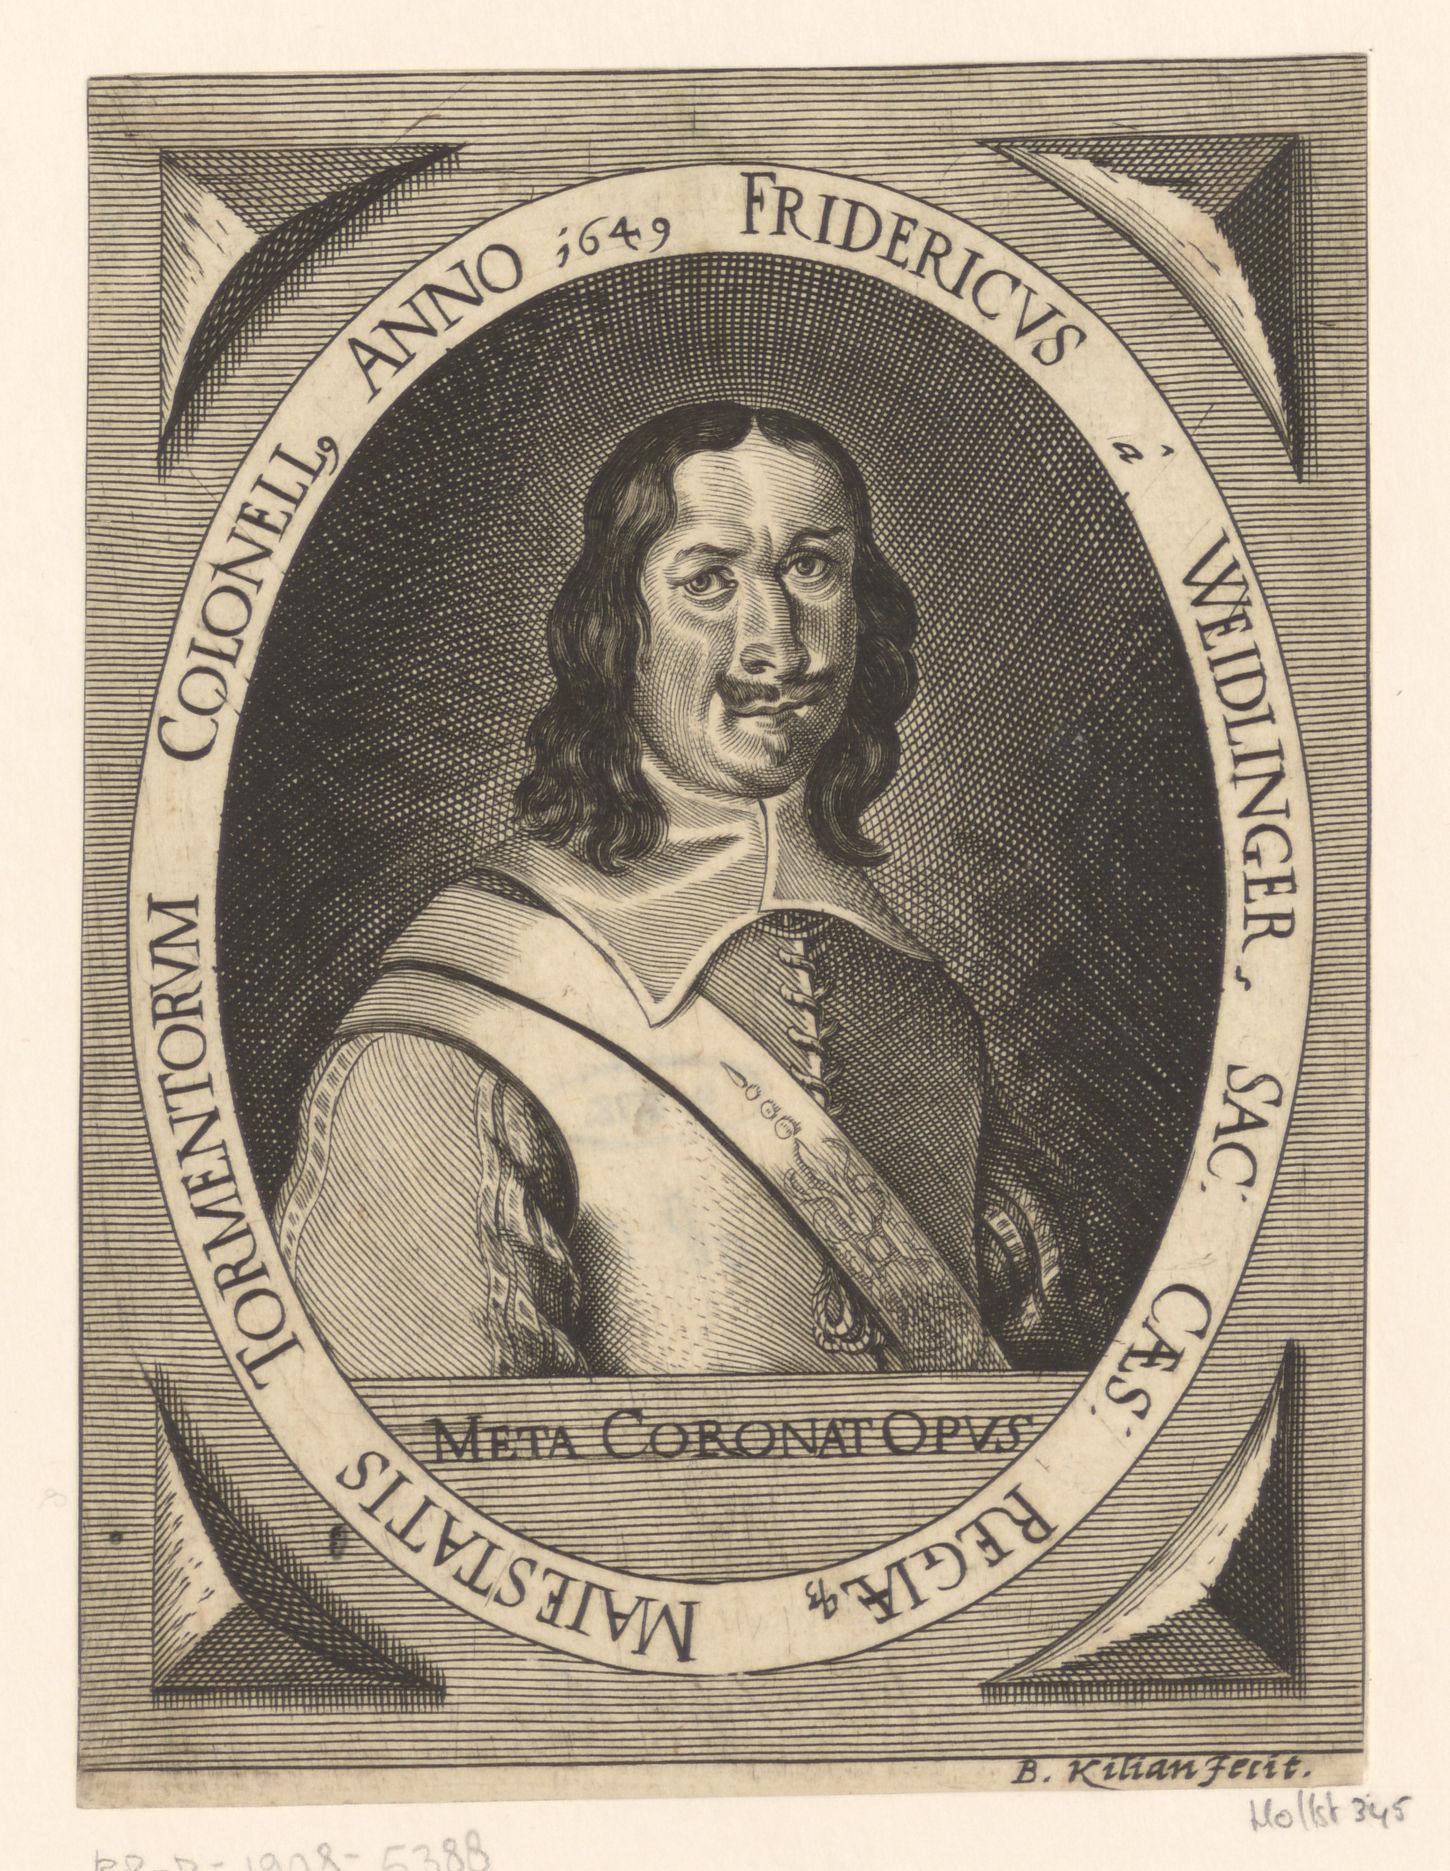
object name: print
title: Portret van Friedrich Weidlinger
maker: bartholomäus kilian (ii)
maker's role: artist, draughtsman, print maker, publisher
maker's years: 1630-1696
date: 1649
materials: paper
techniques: engraving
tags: historical persons, officer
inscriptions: collector's mark: Lugt 2228